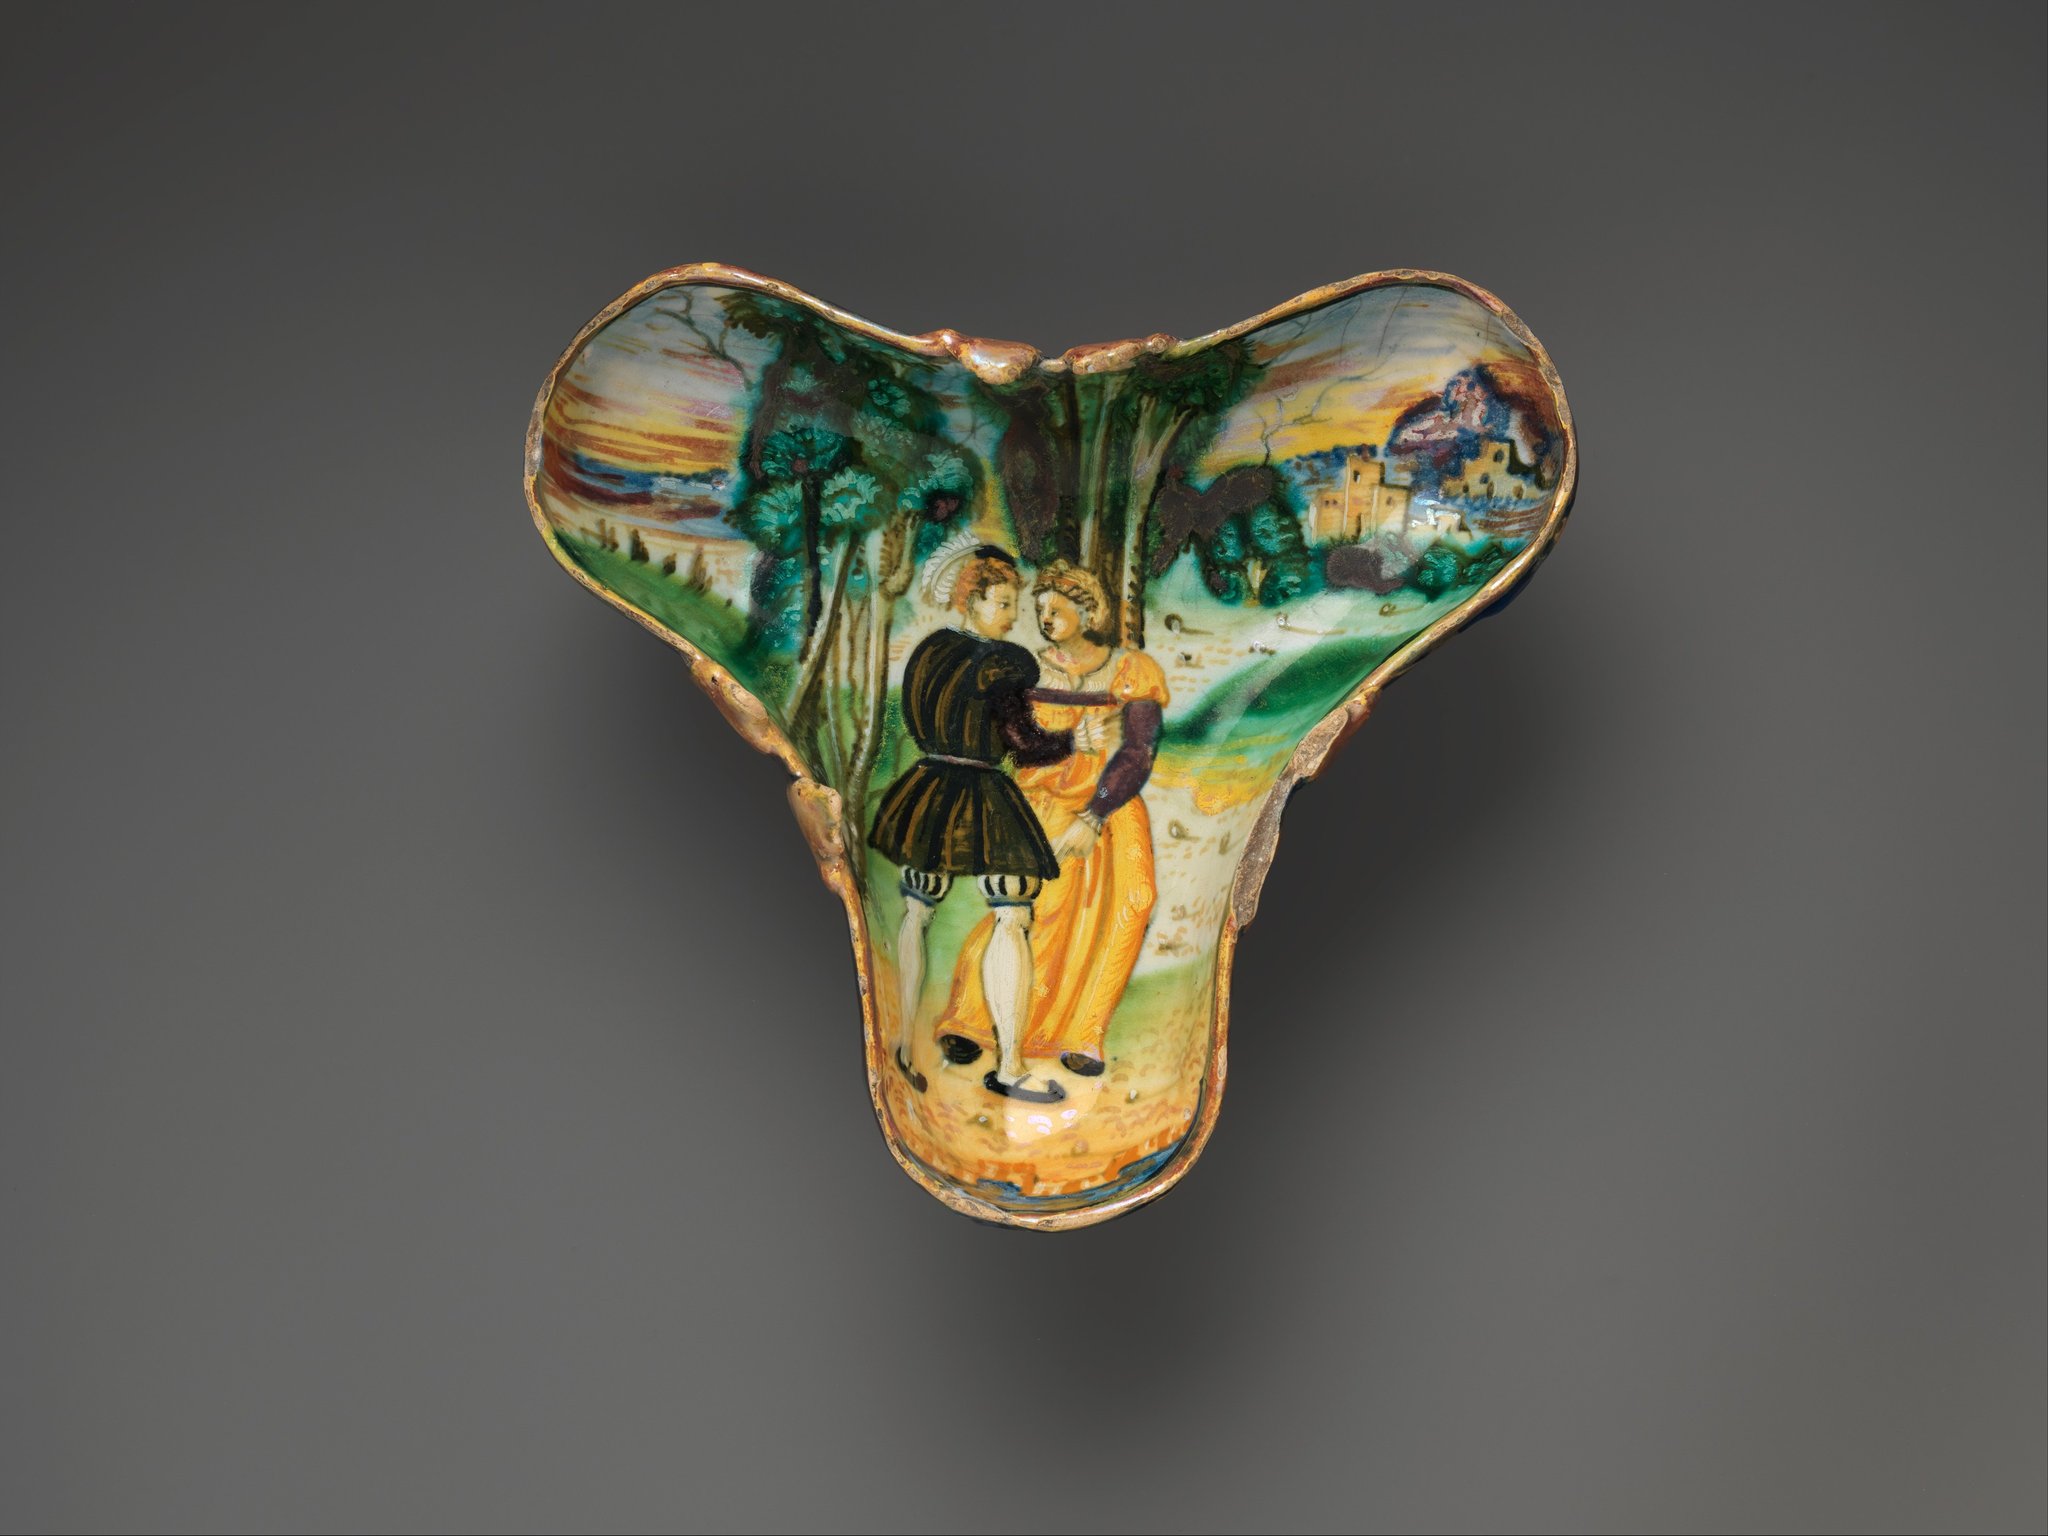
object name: trilobed vessel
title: Trilobed vessel with Two Lovers in a Landscape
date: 1540-1545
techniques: maiolica, glazing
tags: men,lovers,women